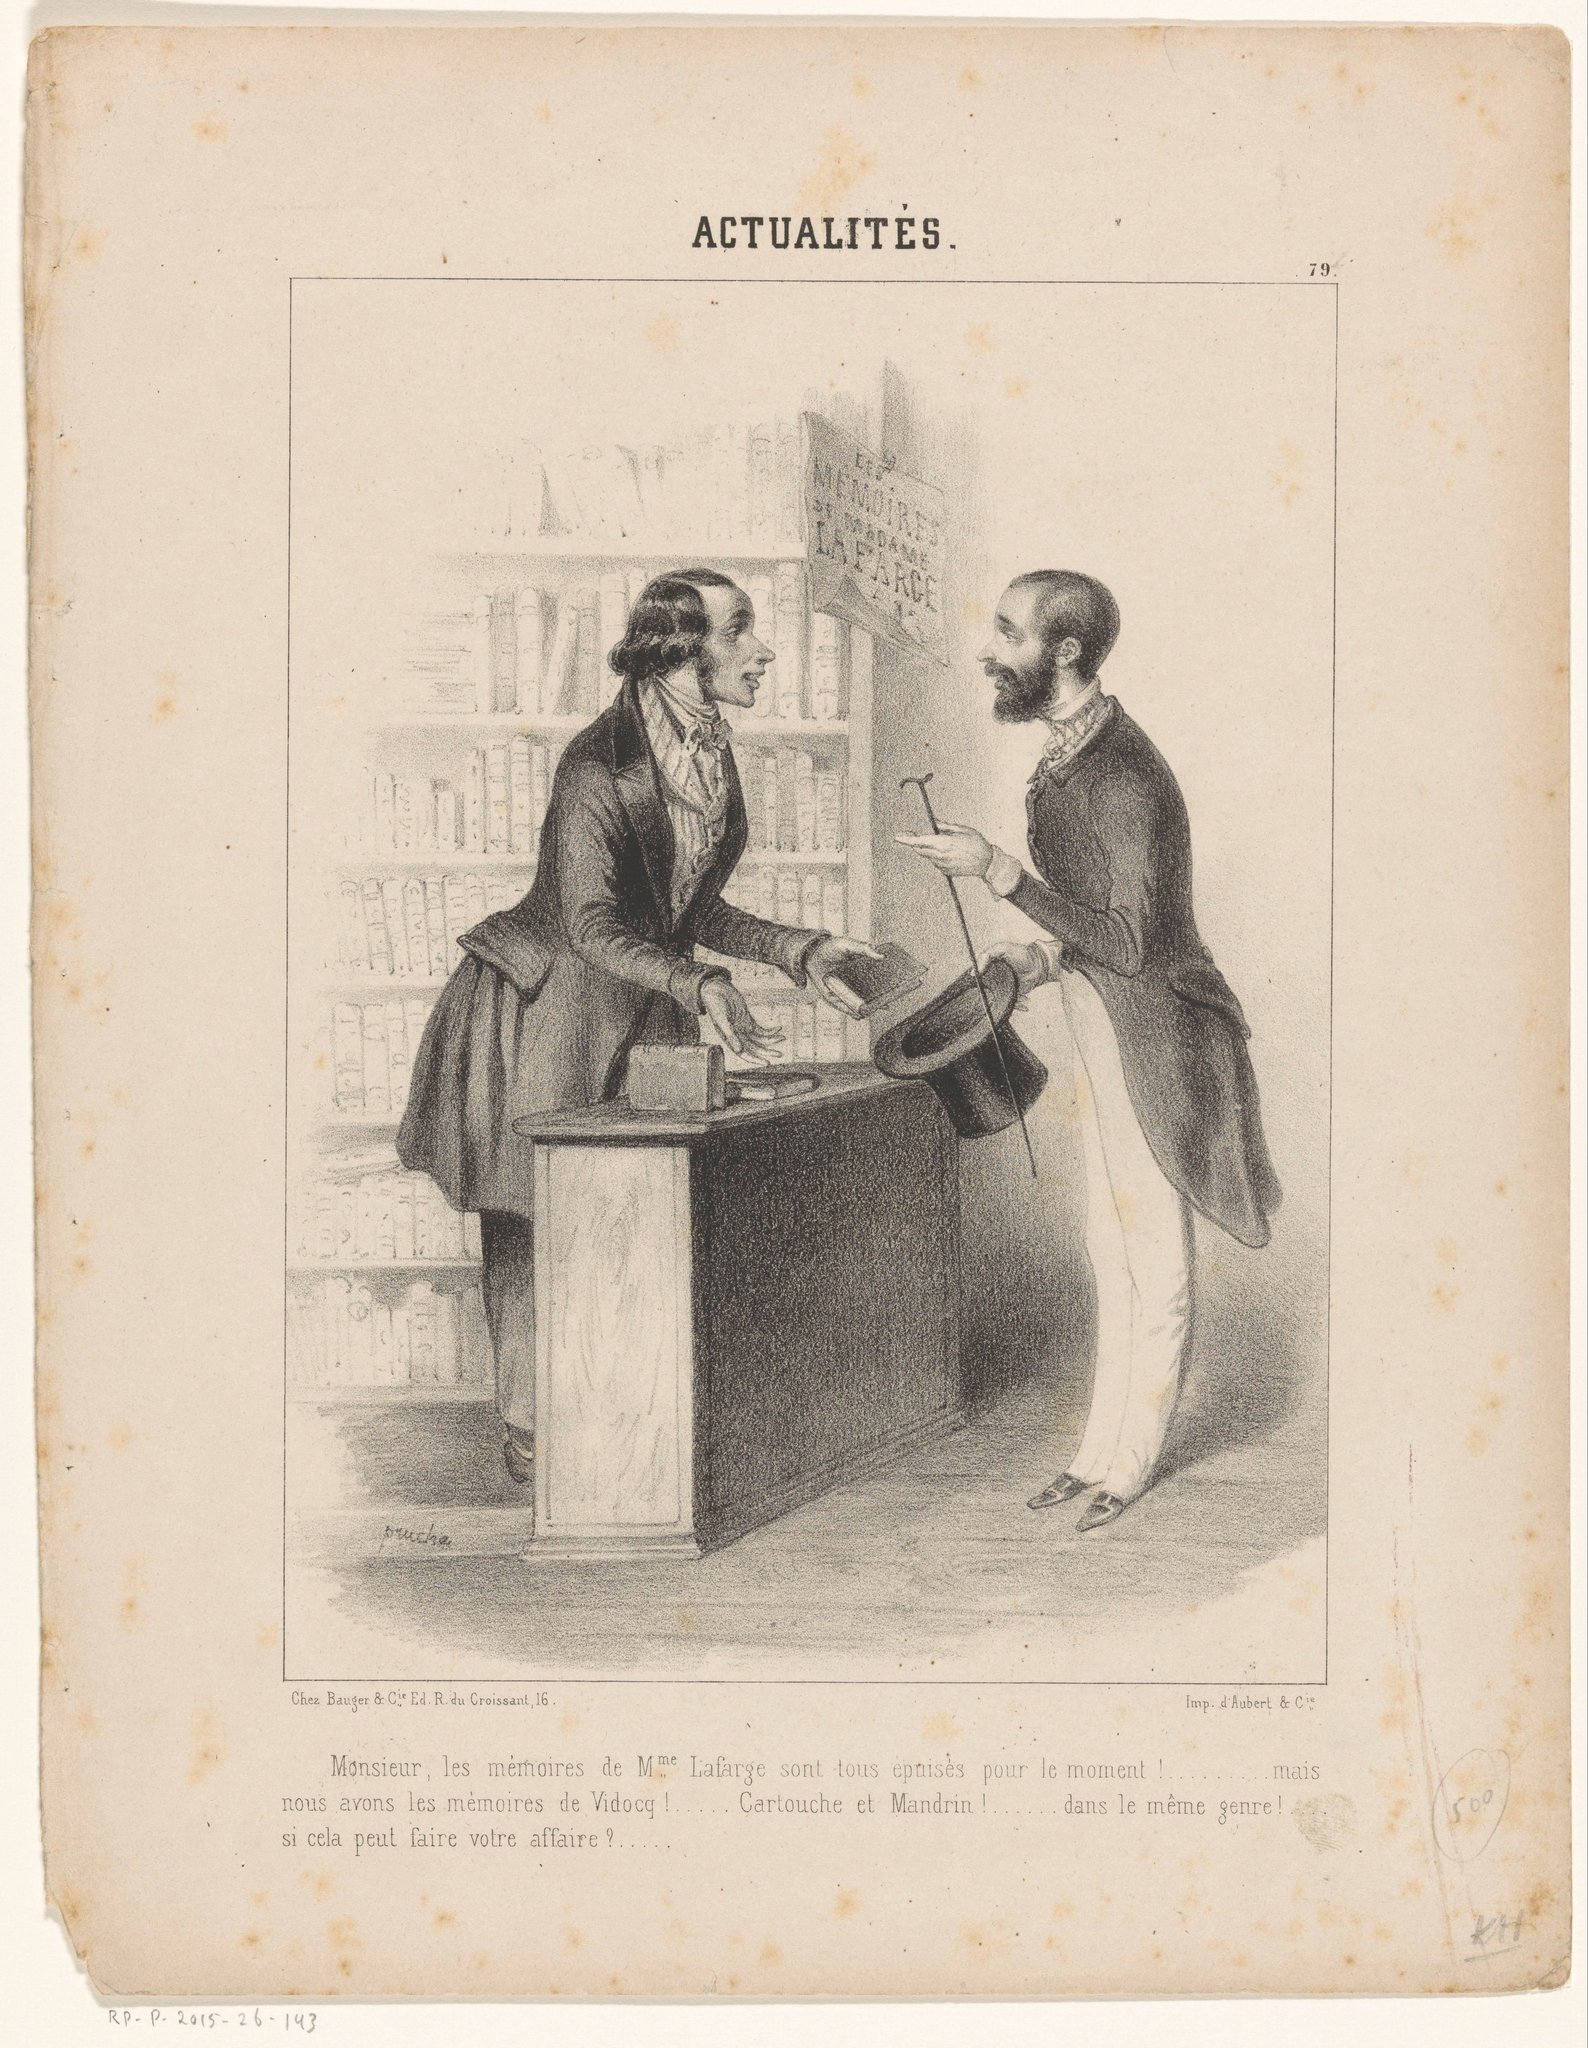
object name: print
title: Actualités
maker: clément pruche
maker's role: print maker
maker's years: -1870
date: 1841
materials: paper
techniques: lithograph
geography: paris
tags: book-shop, bookseller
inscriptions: collector's mark: Lugt 2228, collector's mark: Lugt 4780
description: De boekhandelaar vertelt een klant dat de mémoires van Marie Lafarge uitverkocht zijn. Zij was de hoofdverdachte in een geruchtmakende rechtszaak en werd ervan verdacht haar man te hebben vermoord door middel van arsenicum. De boekverkoper heeft wel vergelijkbare werken op voorraad van Franse criminelen als Eugène François Vidocq, Louis Dominique Cartouche en Louis Mandrin. Rechtsboven genummerd: 79.